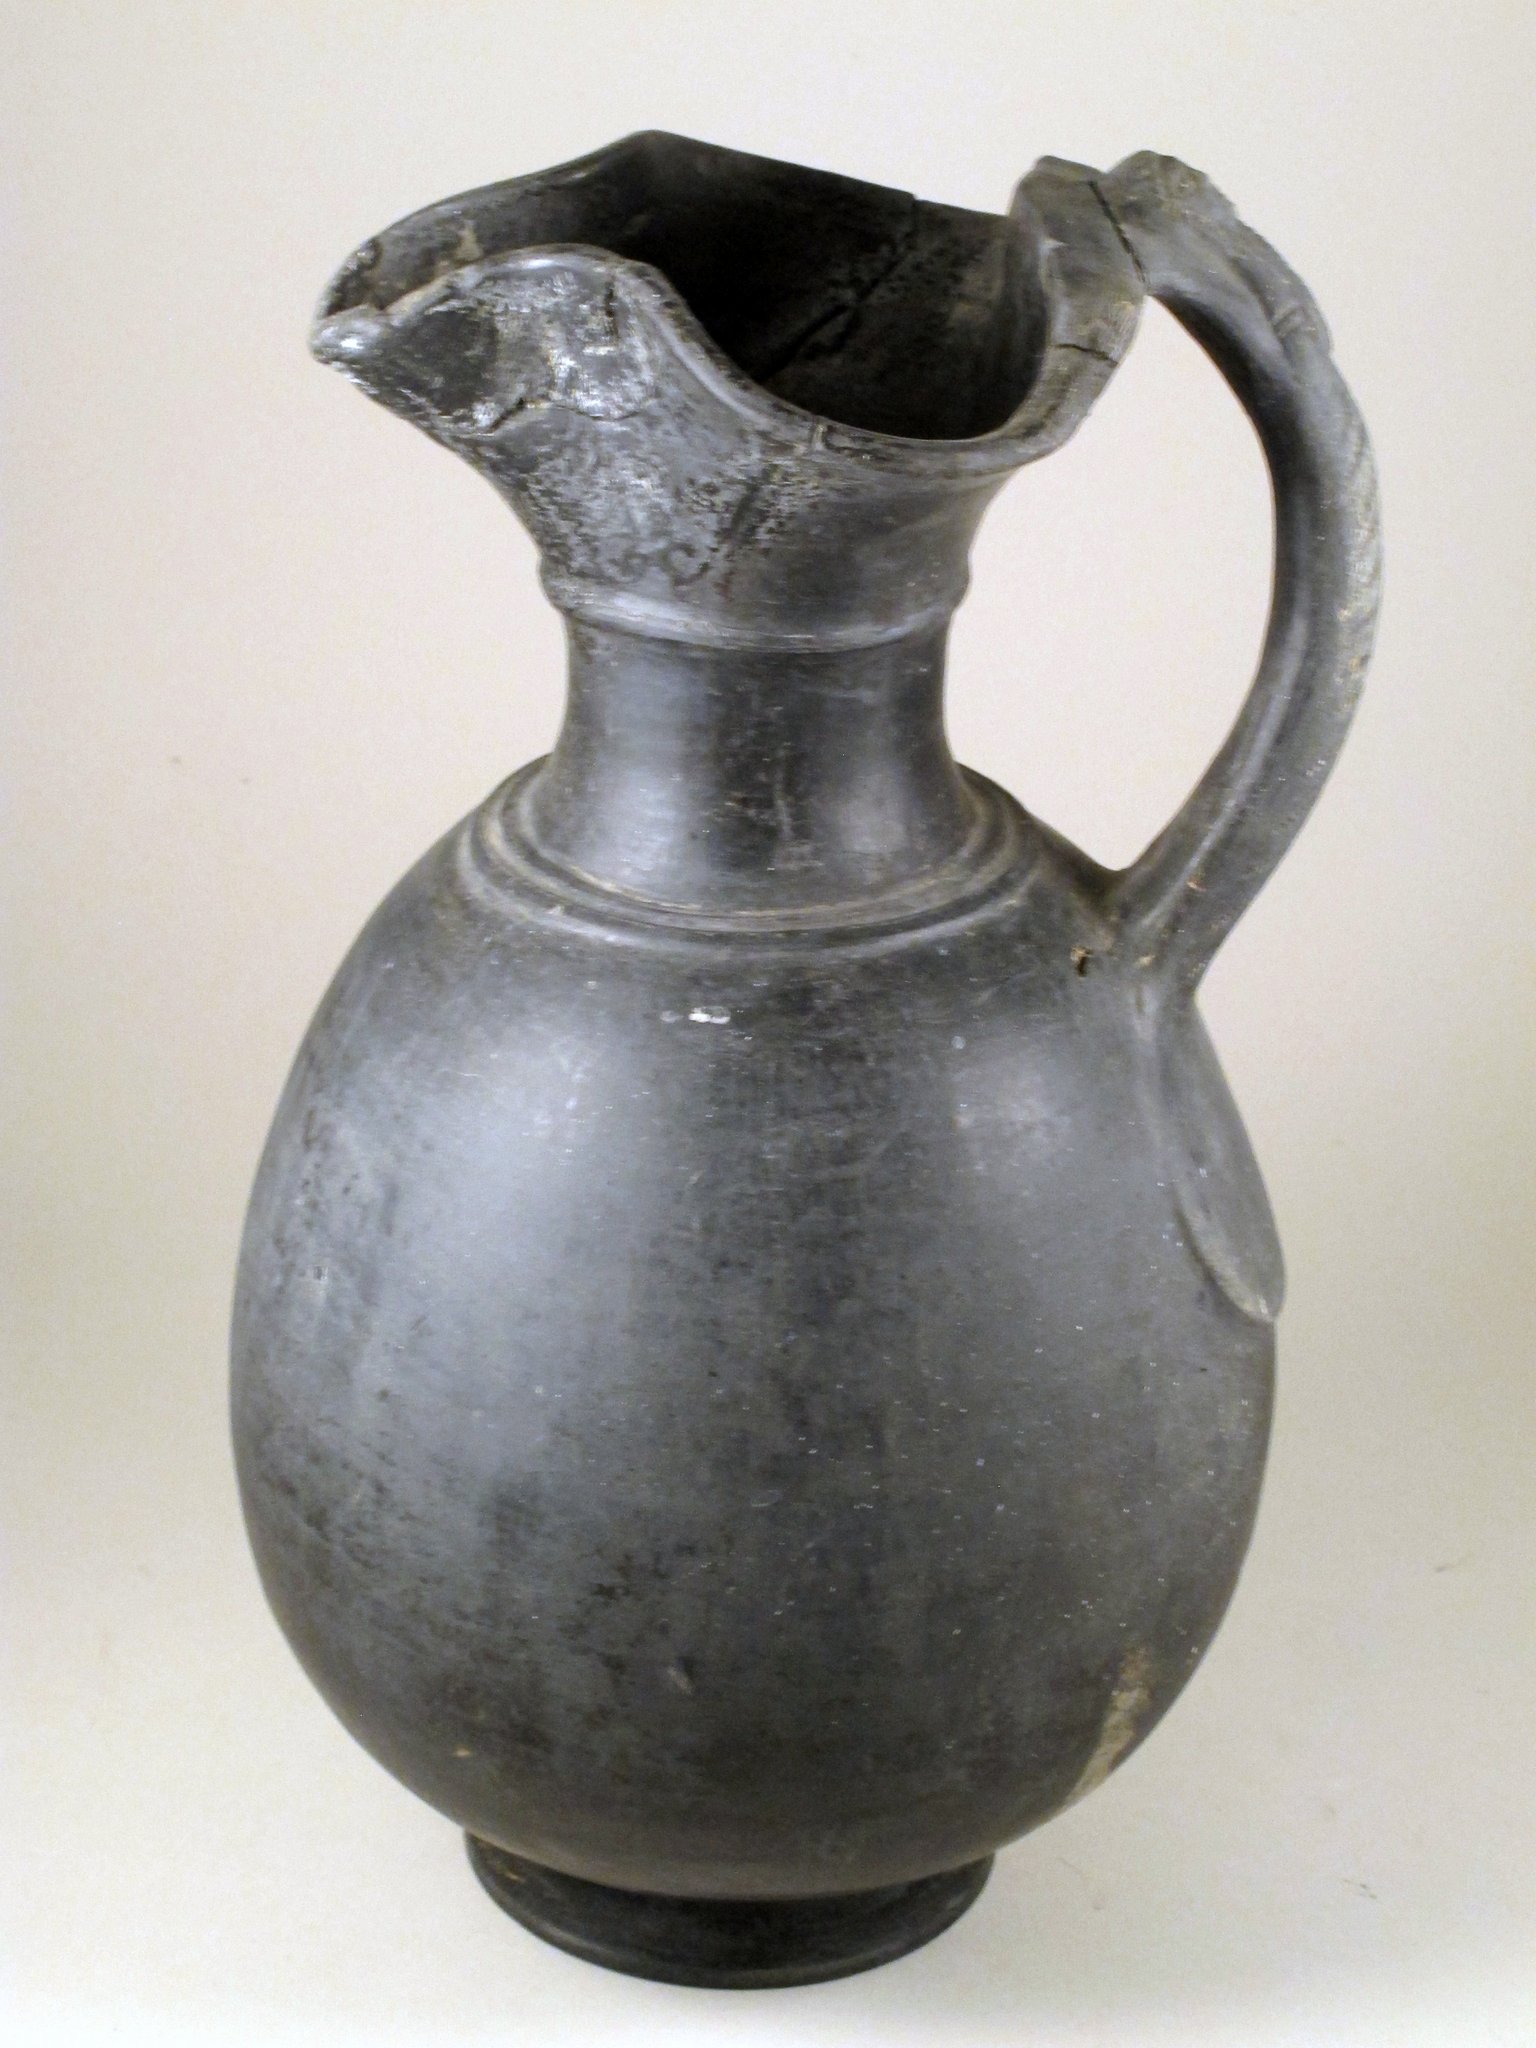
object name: oinochoe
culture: etruscan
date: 567-535 BCE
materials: terracotta